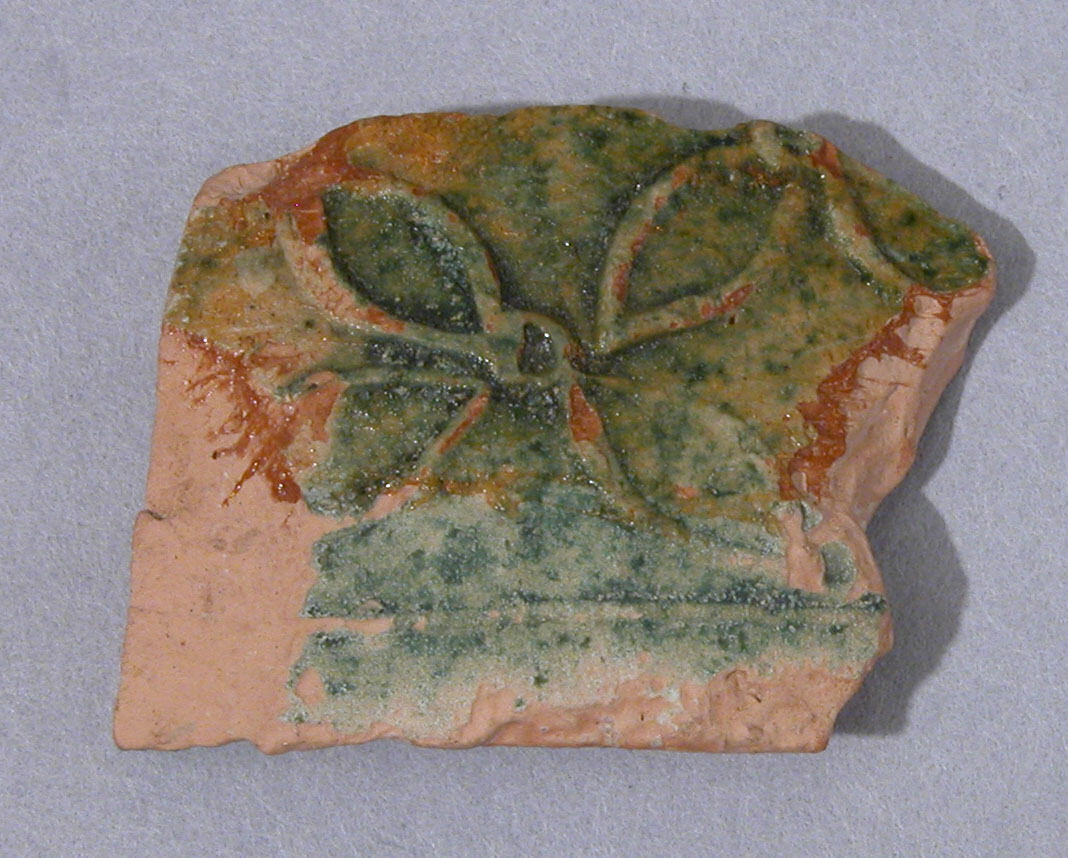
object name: fragment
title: Ceramic Fragment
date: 801-900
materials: earthenware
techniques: glazing, molding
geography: saudi arabia